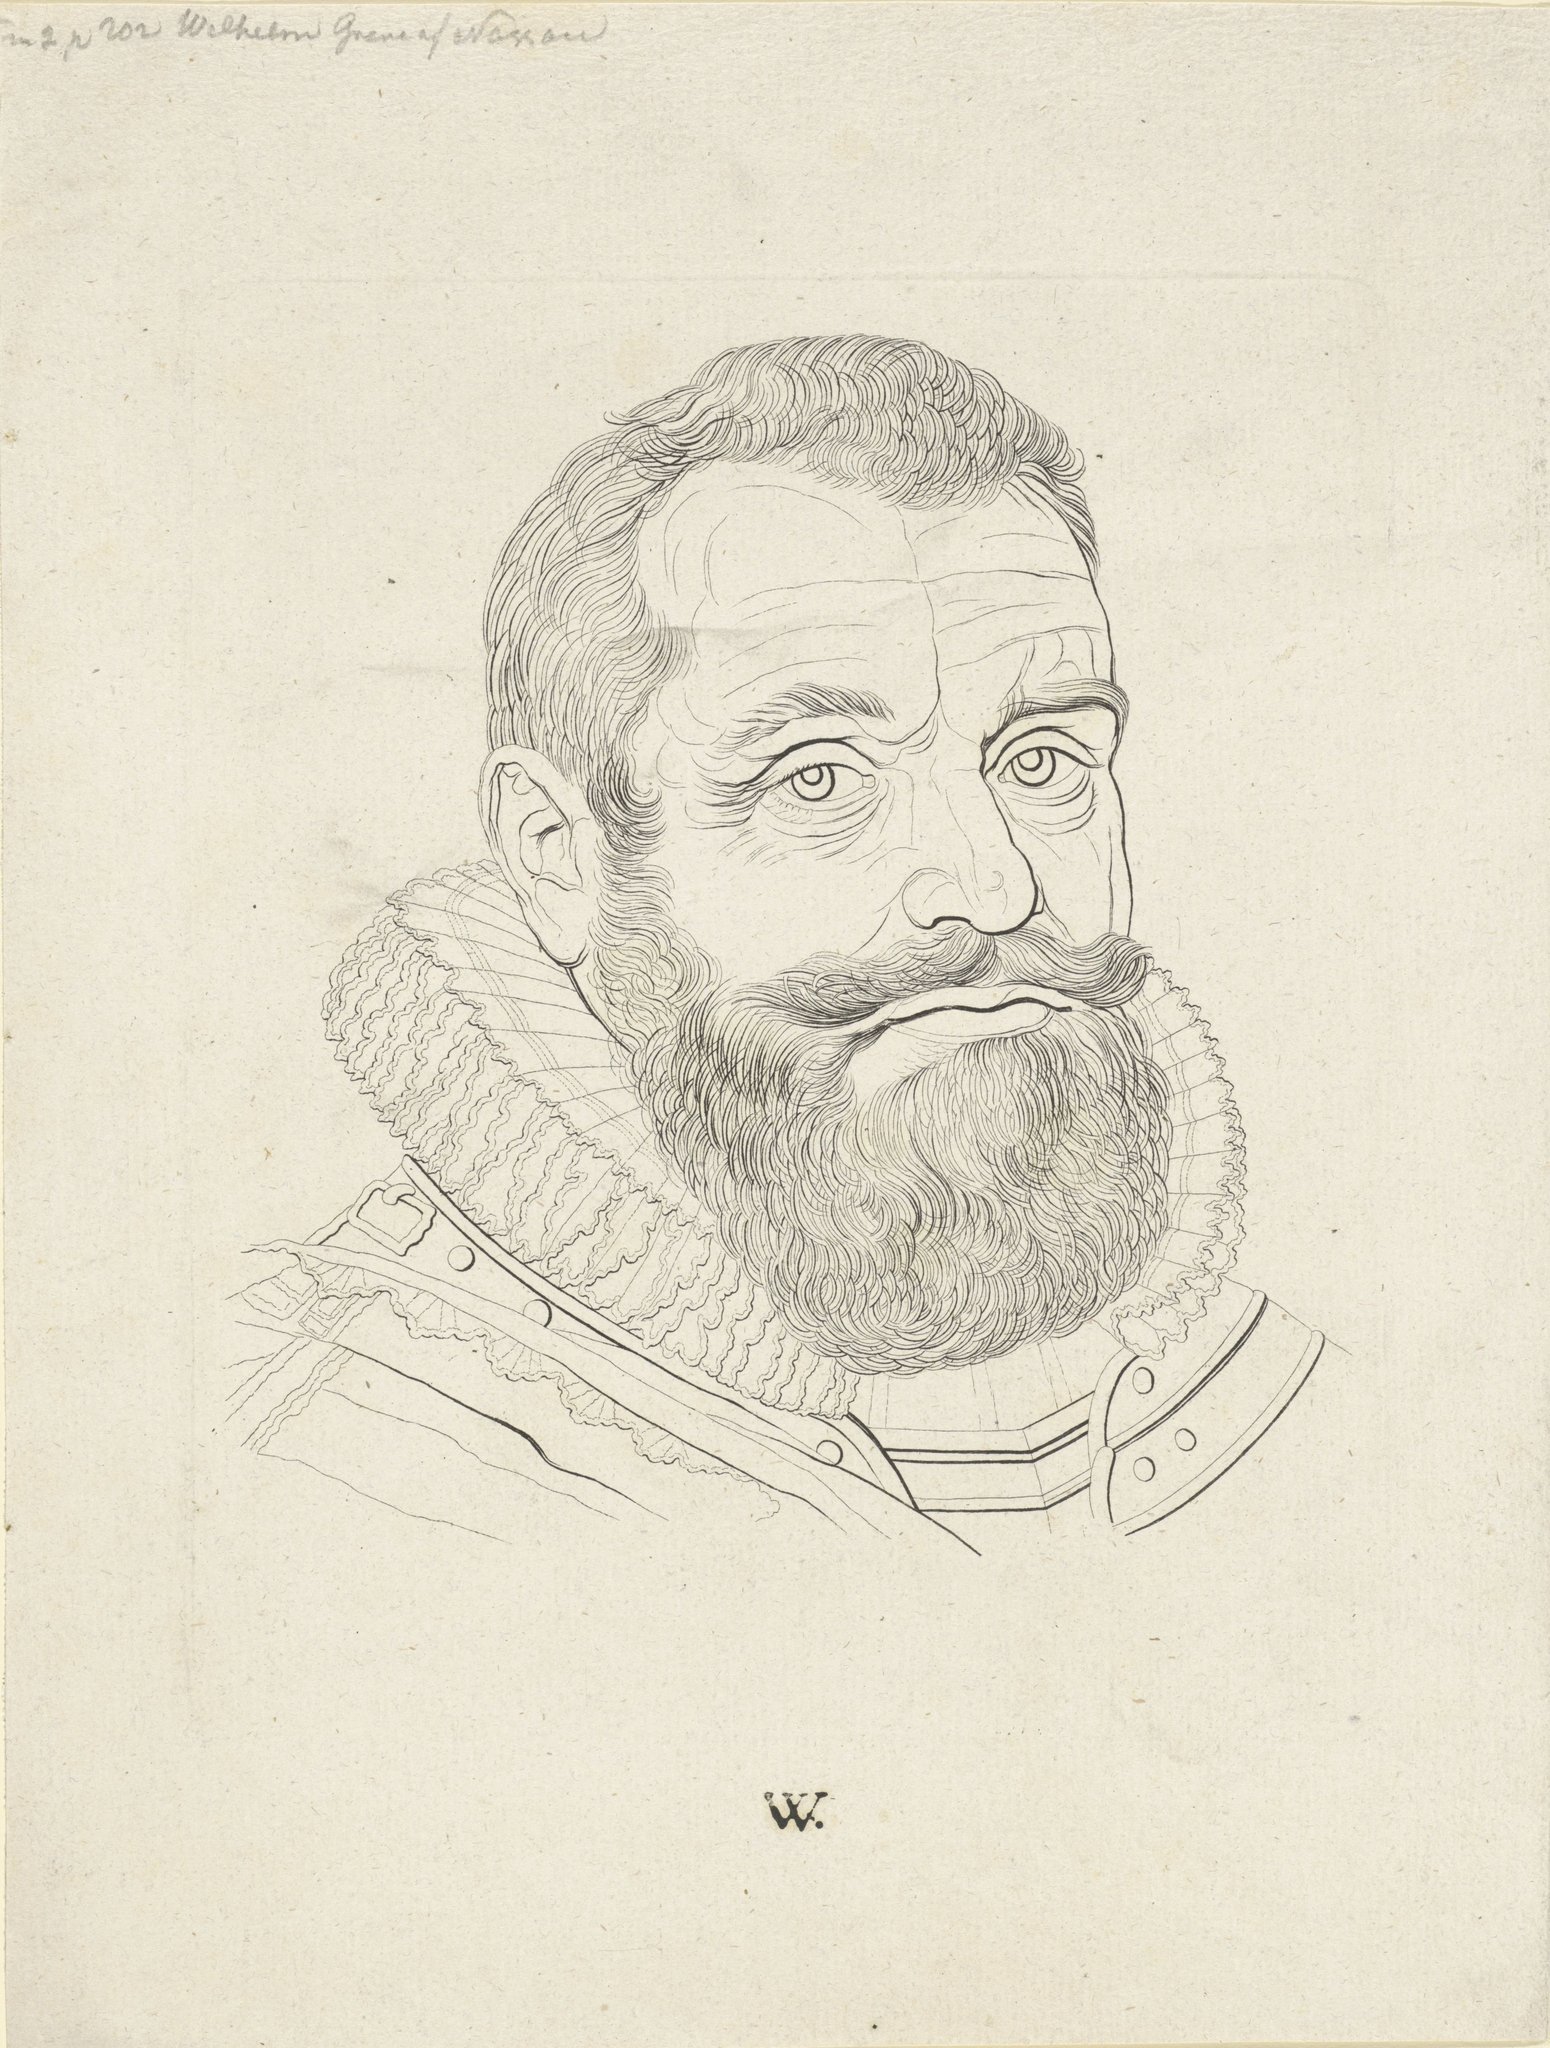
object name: print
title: Portret van Willem Lodewijk, graaf van Nassau-Dillenburg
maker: Anonymous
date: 1600-1699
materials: paper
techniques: engraving, etching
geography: low countries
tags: willem lodewijk graaf van nassau-dillenburg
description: De hier vermelde titel verwijst naar de hoogst verkregen titel van de geportretteerde, niet per se naar de titel die de geportretteerde op deze voorstelling draagt.